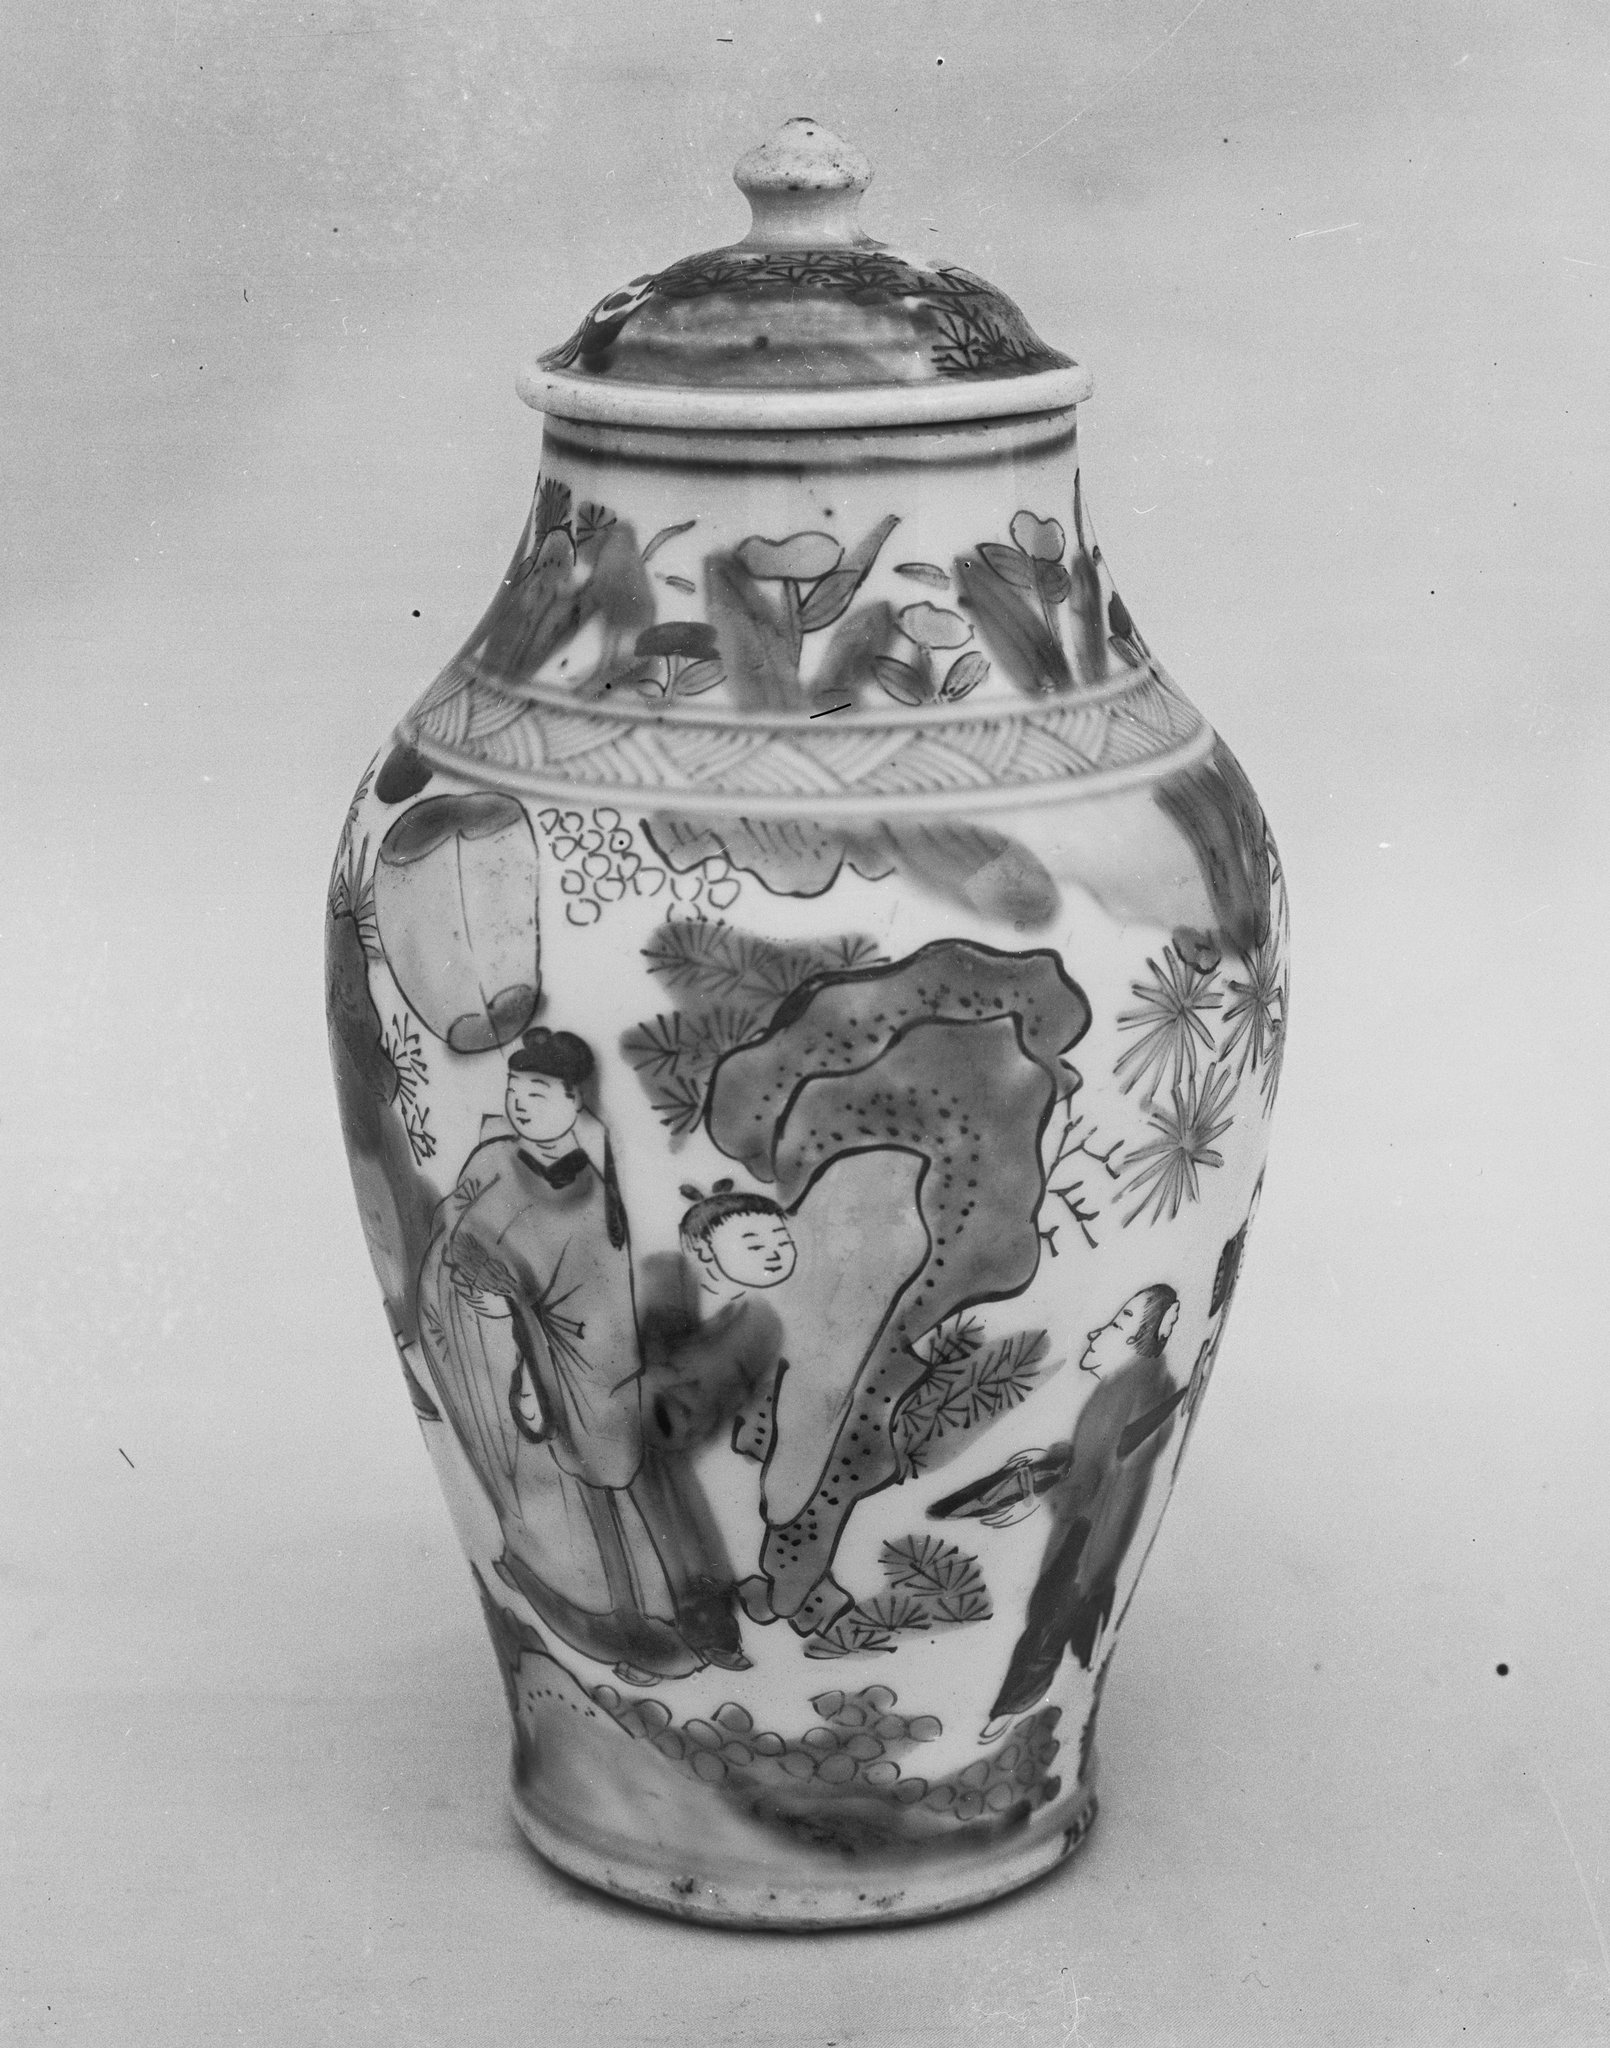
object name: covered jar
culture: chinese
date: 1601-1650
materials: enamel, porcelain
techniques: overglaze, painting, polychrome, underglaze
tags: human figures